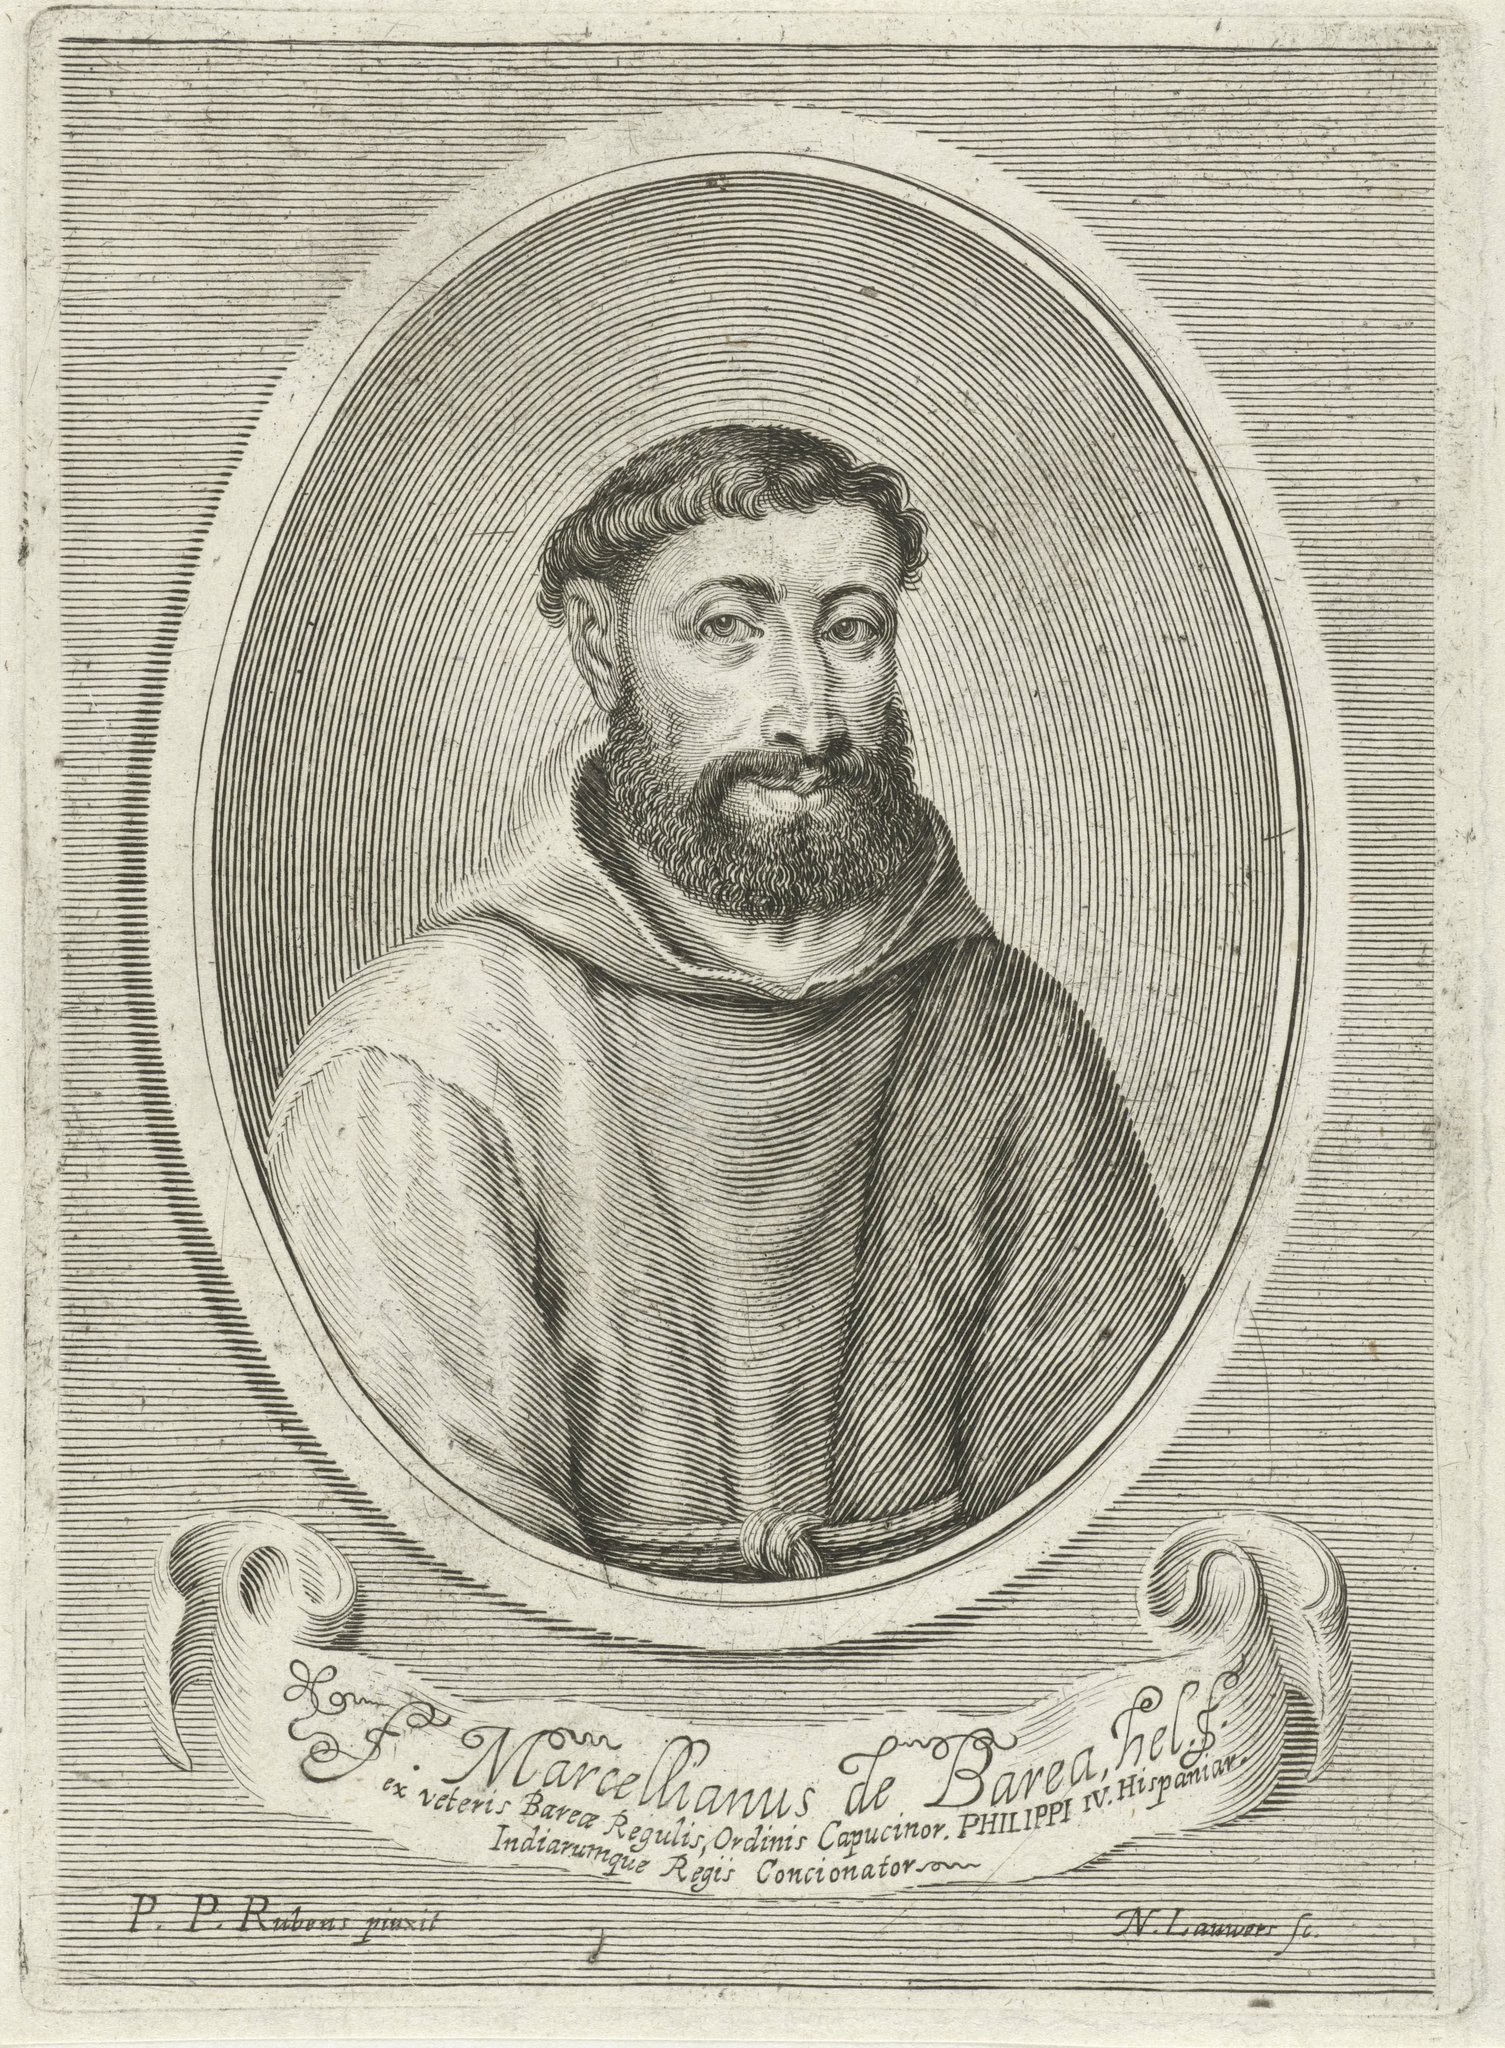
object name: print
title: Portret van Marcellianus de Barea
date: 1619-1652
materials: paper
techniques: engraving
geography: antwerp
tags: minderbroeder, marcellianus de barea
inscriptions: collector's mark: Lugt 2228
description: Portretbuste in ovaal naar rechts van de Spaanse monnik Marcellianus de Barea, gehuld in een habijt. Op een banderol onder het ovaal staat de naam van de geportretteerde, gevolgd door een tweeregelige tekst in Latijn.